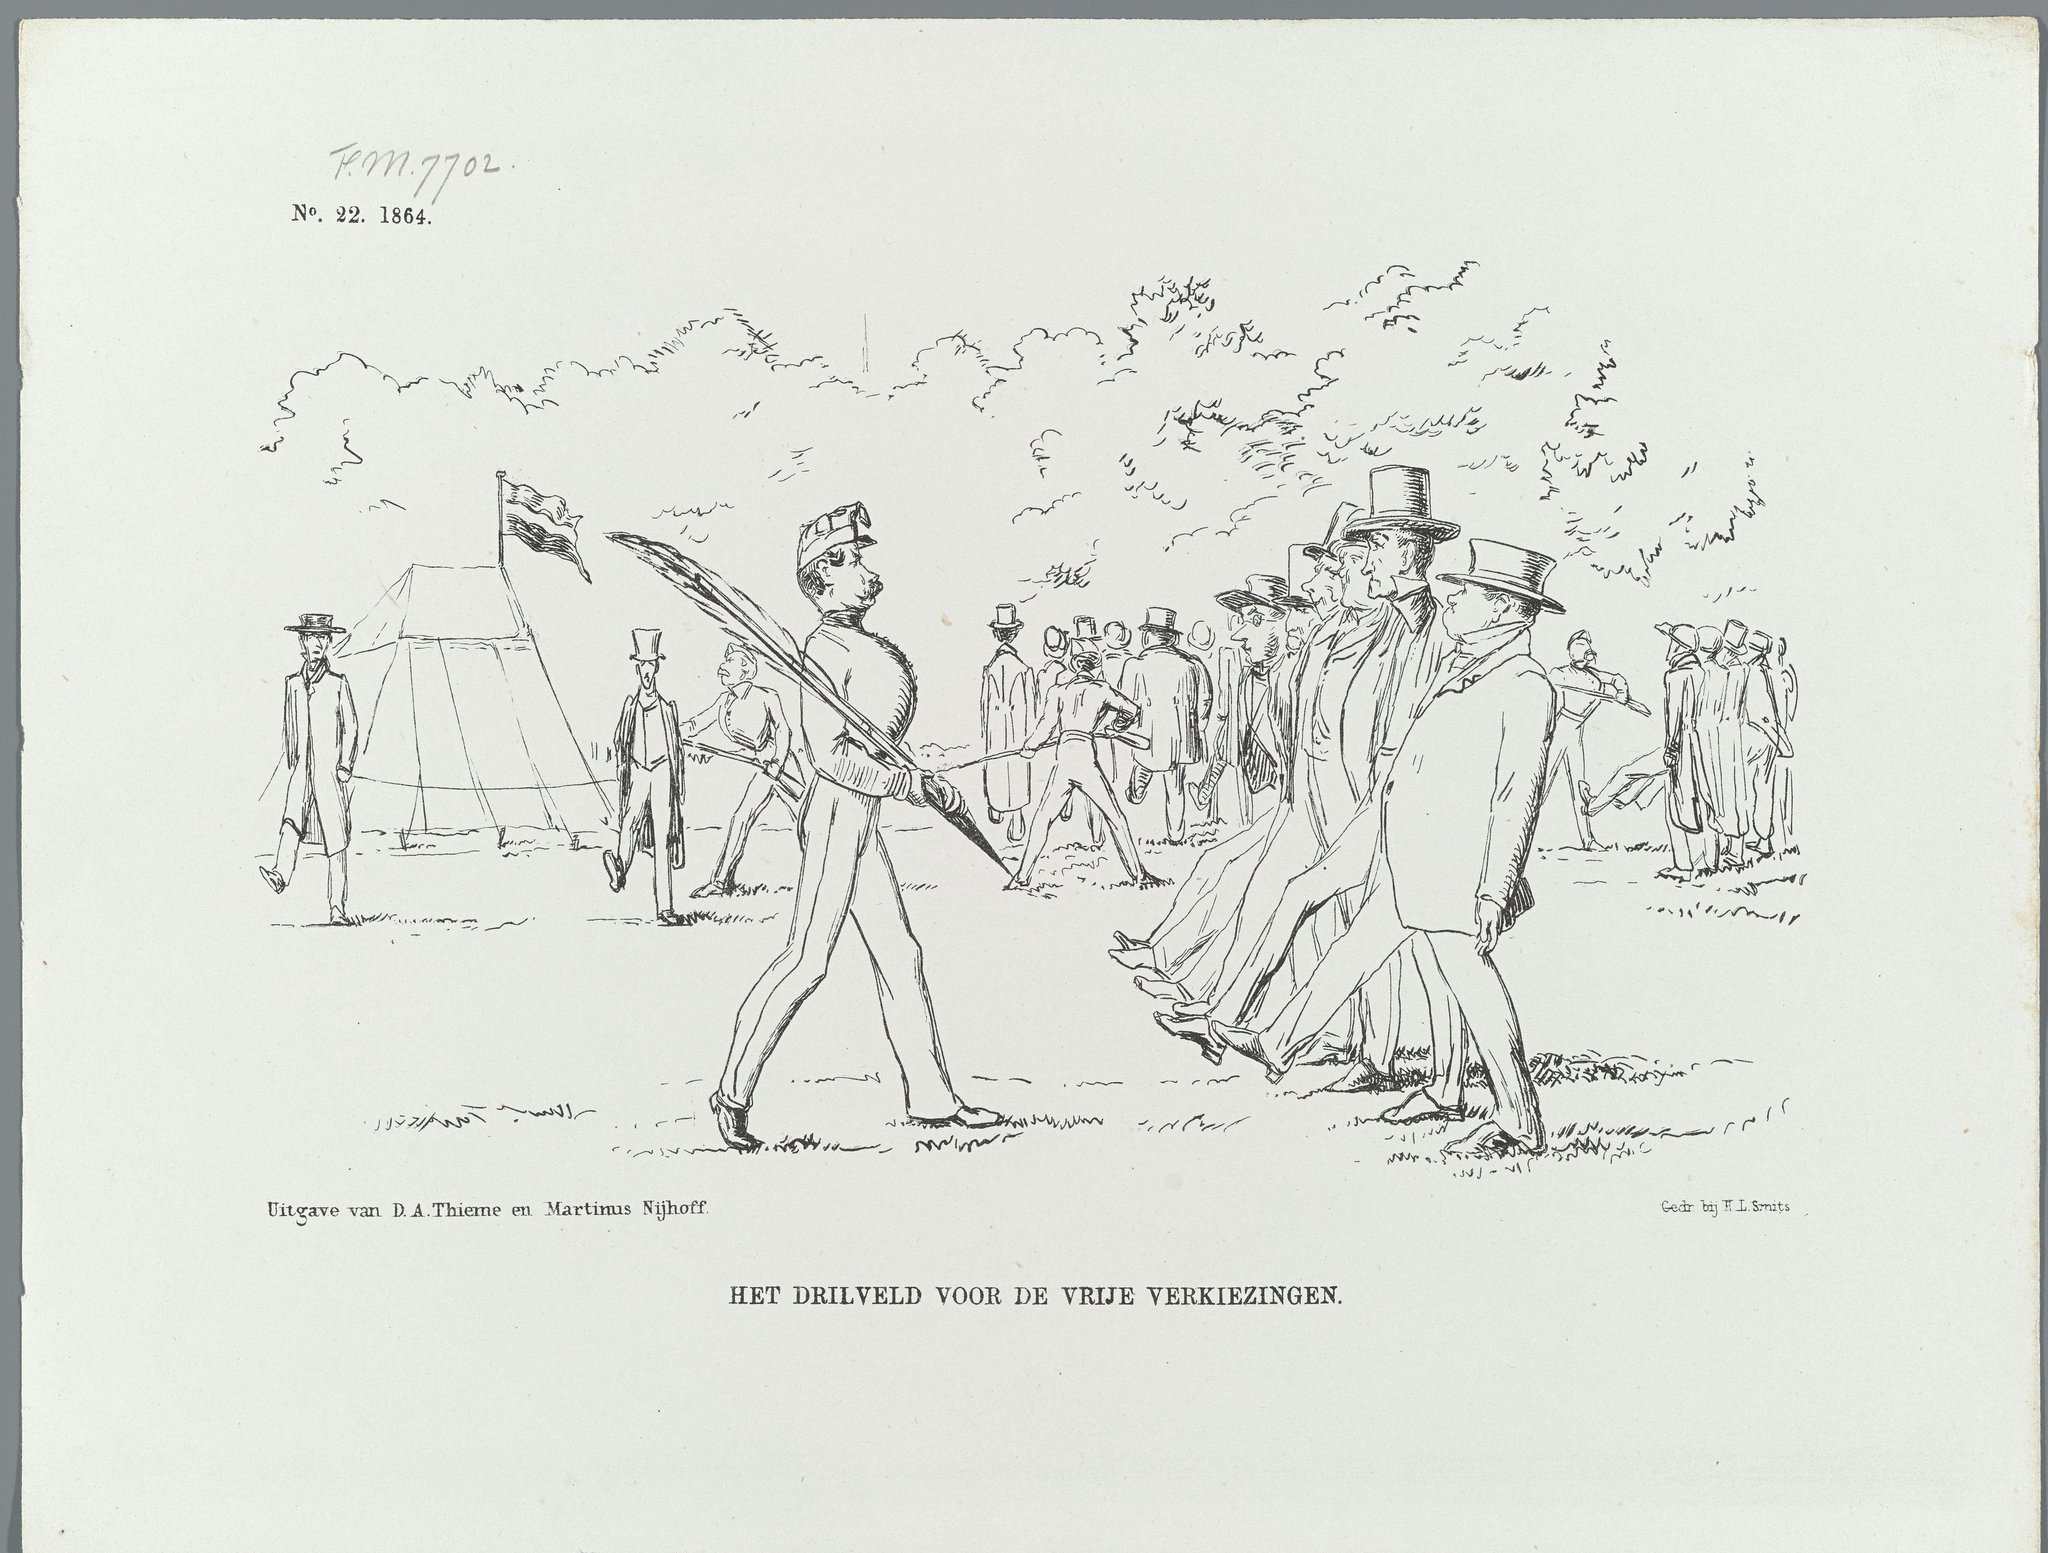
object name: cartoon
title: Het drilveld voor de vrije verkiezingen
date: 1864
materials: paper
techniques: lithograph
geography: netherlands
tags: drill ~ military training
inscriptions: collector's mark: Lugt 2228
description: Spotprent op de verschillende politieke programma's bij de aanstaande verkiezingen. Politici worden door een korporaal gewapend met een pen gedrild. Plaat verschenen bij het weekblad De Nederlandsche Spectator, nr. 22, 28 april 1864.